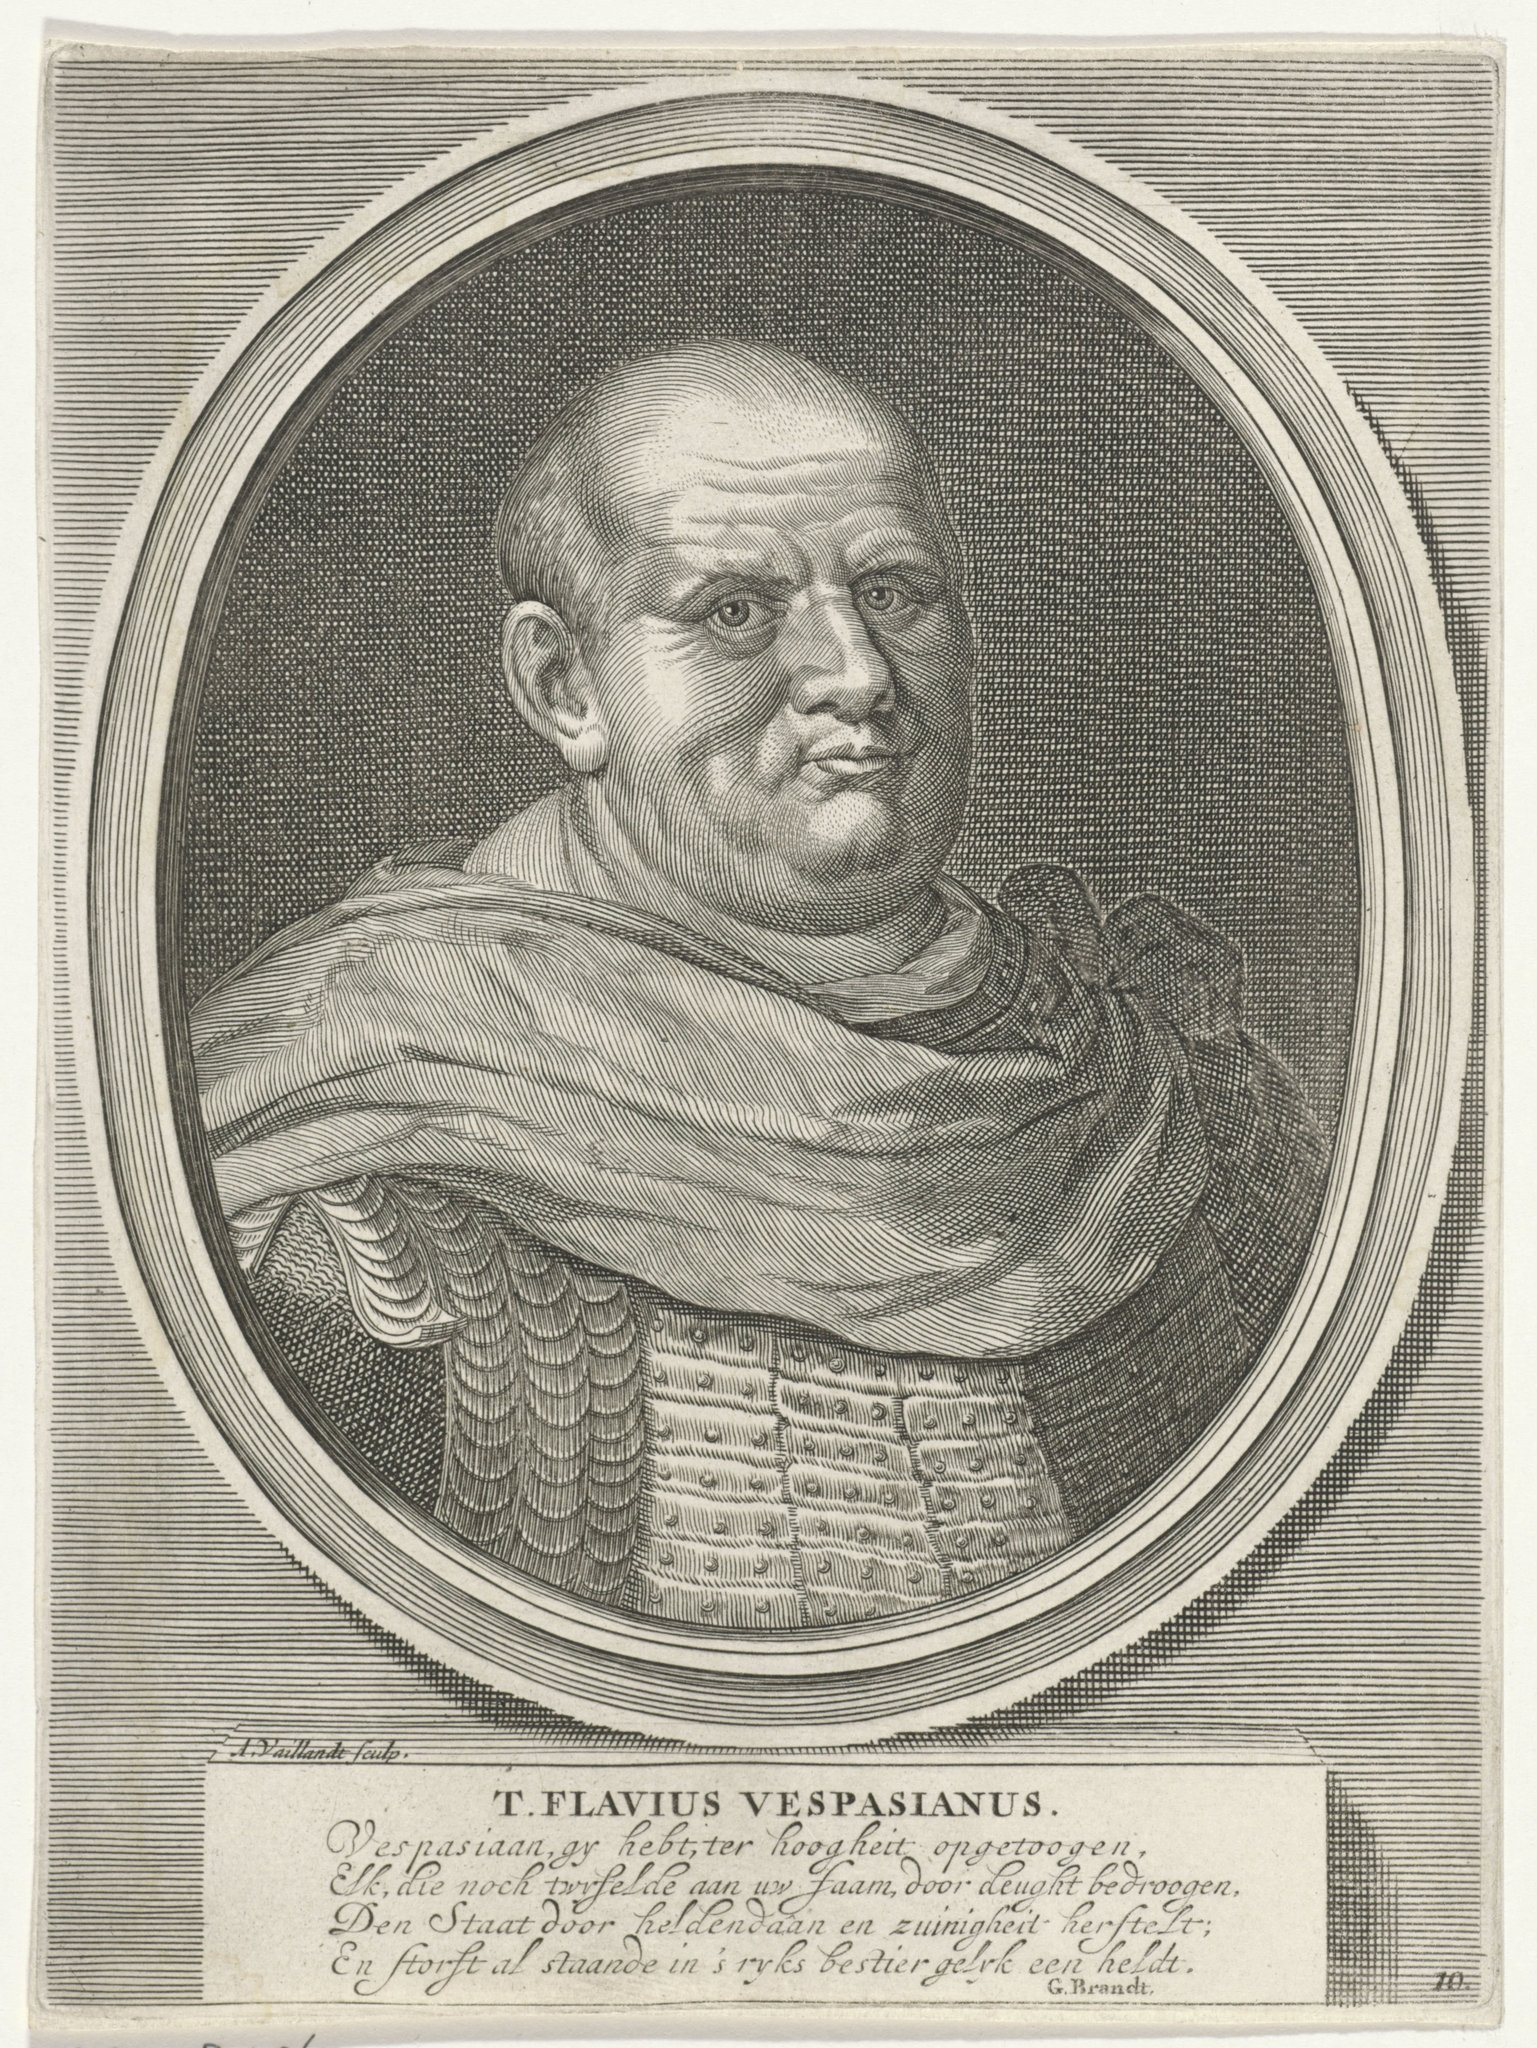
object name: print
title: Romeinse portretten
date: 1665-1693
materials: paper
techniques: engraving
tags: cittareale, aquae cutiliae, keizer, vespasianus (keizer van het romeinse rijk)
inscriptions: collector's mark: Lugt 2228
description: Portret van Titus Falvius Vespasianus, Romeins keizer. Prent uit een serie van veertien portretten van Romeinse keizers, Germanicus en Seneca.